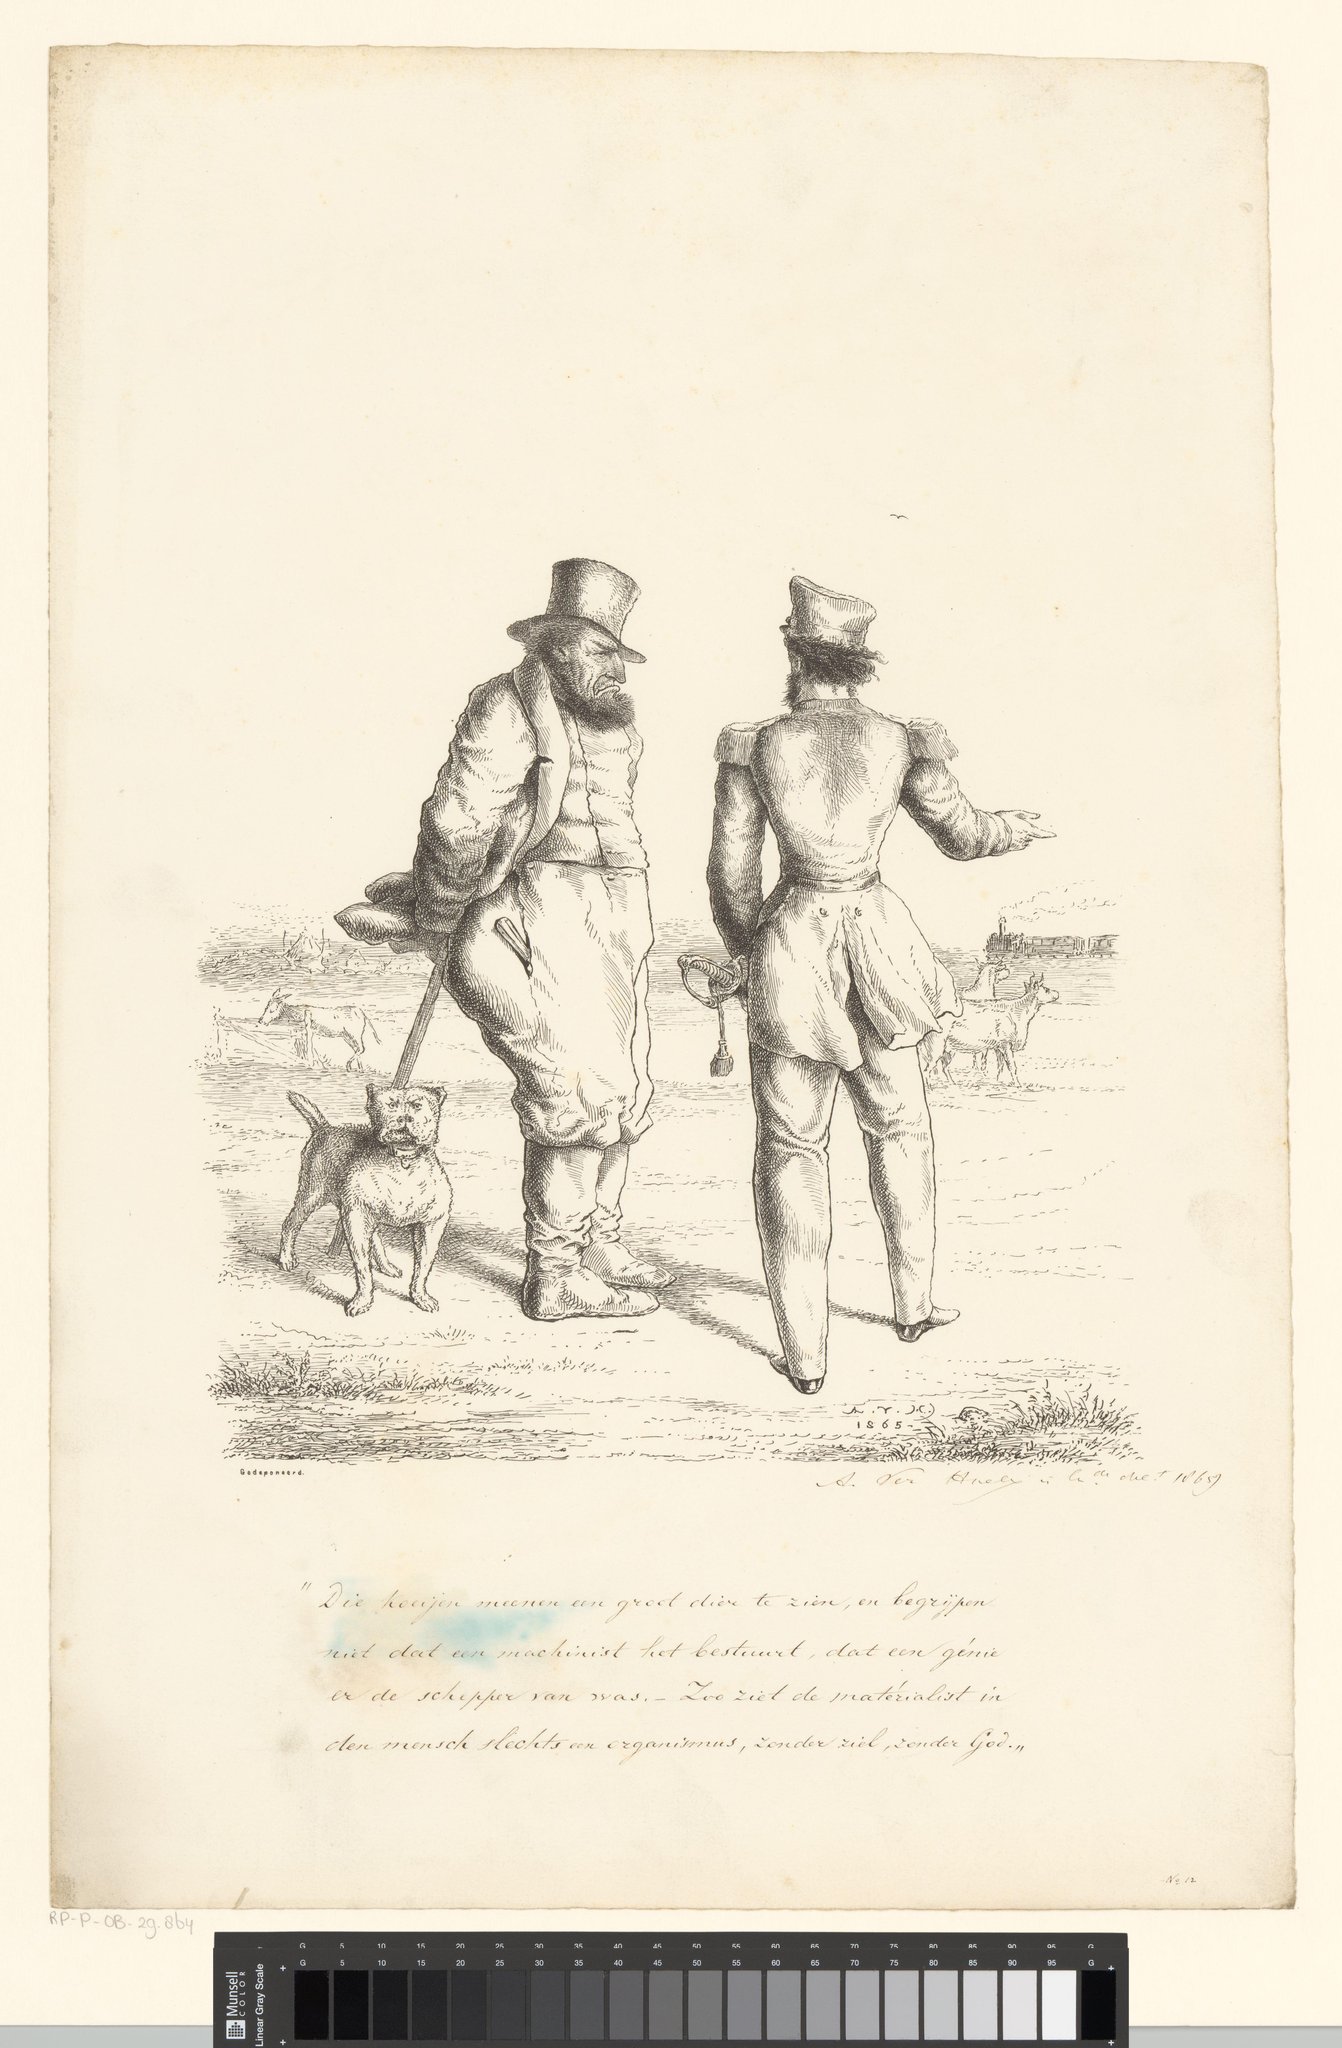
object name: print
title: Twee mannen in gesprek over de trein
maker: alexander ver huell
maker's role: draughtsman, print maker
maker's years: 1822-1897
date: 1864-1866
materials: paper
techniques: lithograph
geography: arnhem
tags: railway, train, conversation, dialogue; conversation piece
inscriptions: collector's mark: Lugt 2228, : ‘Gedeponeerd.’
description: Een oude man met hond is in gesprek met een man op de rug gezien. Zij praten over de trein die in de achtergrond rijdt.